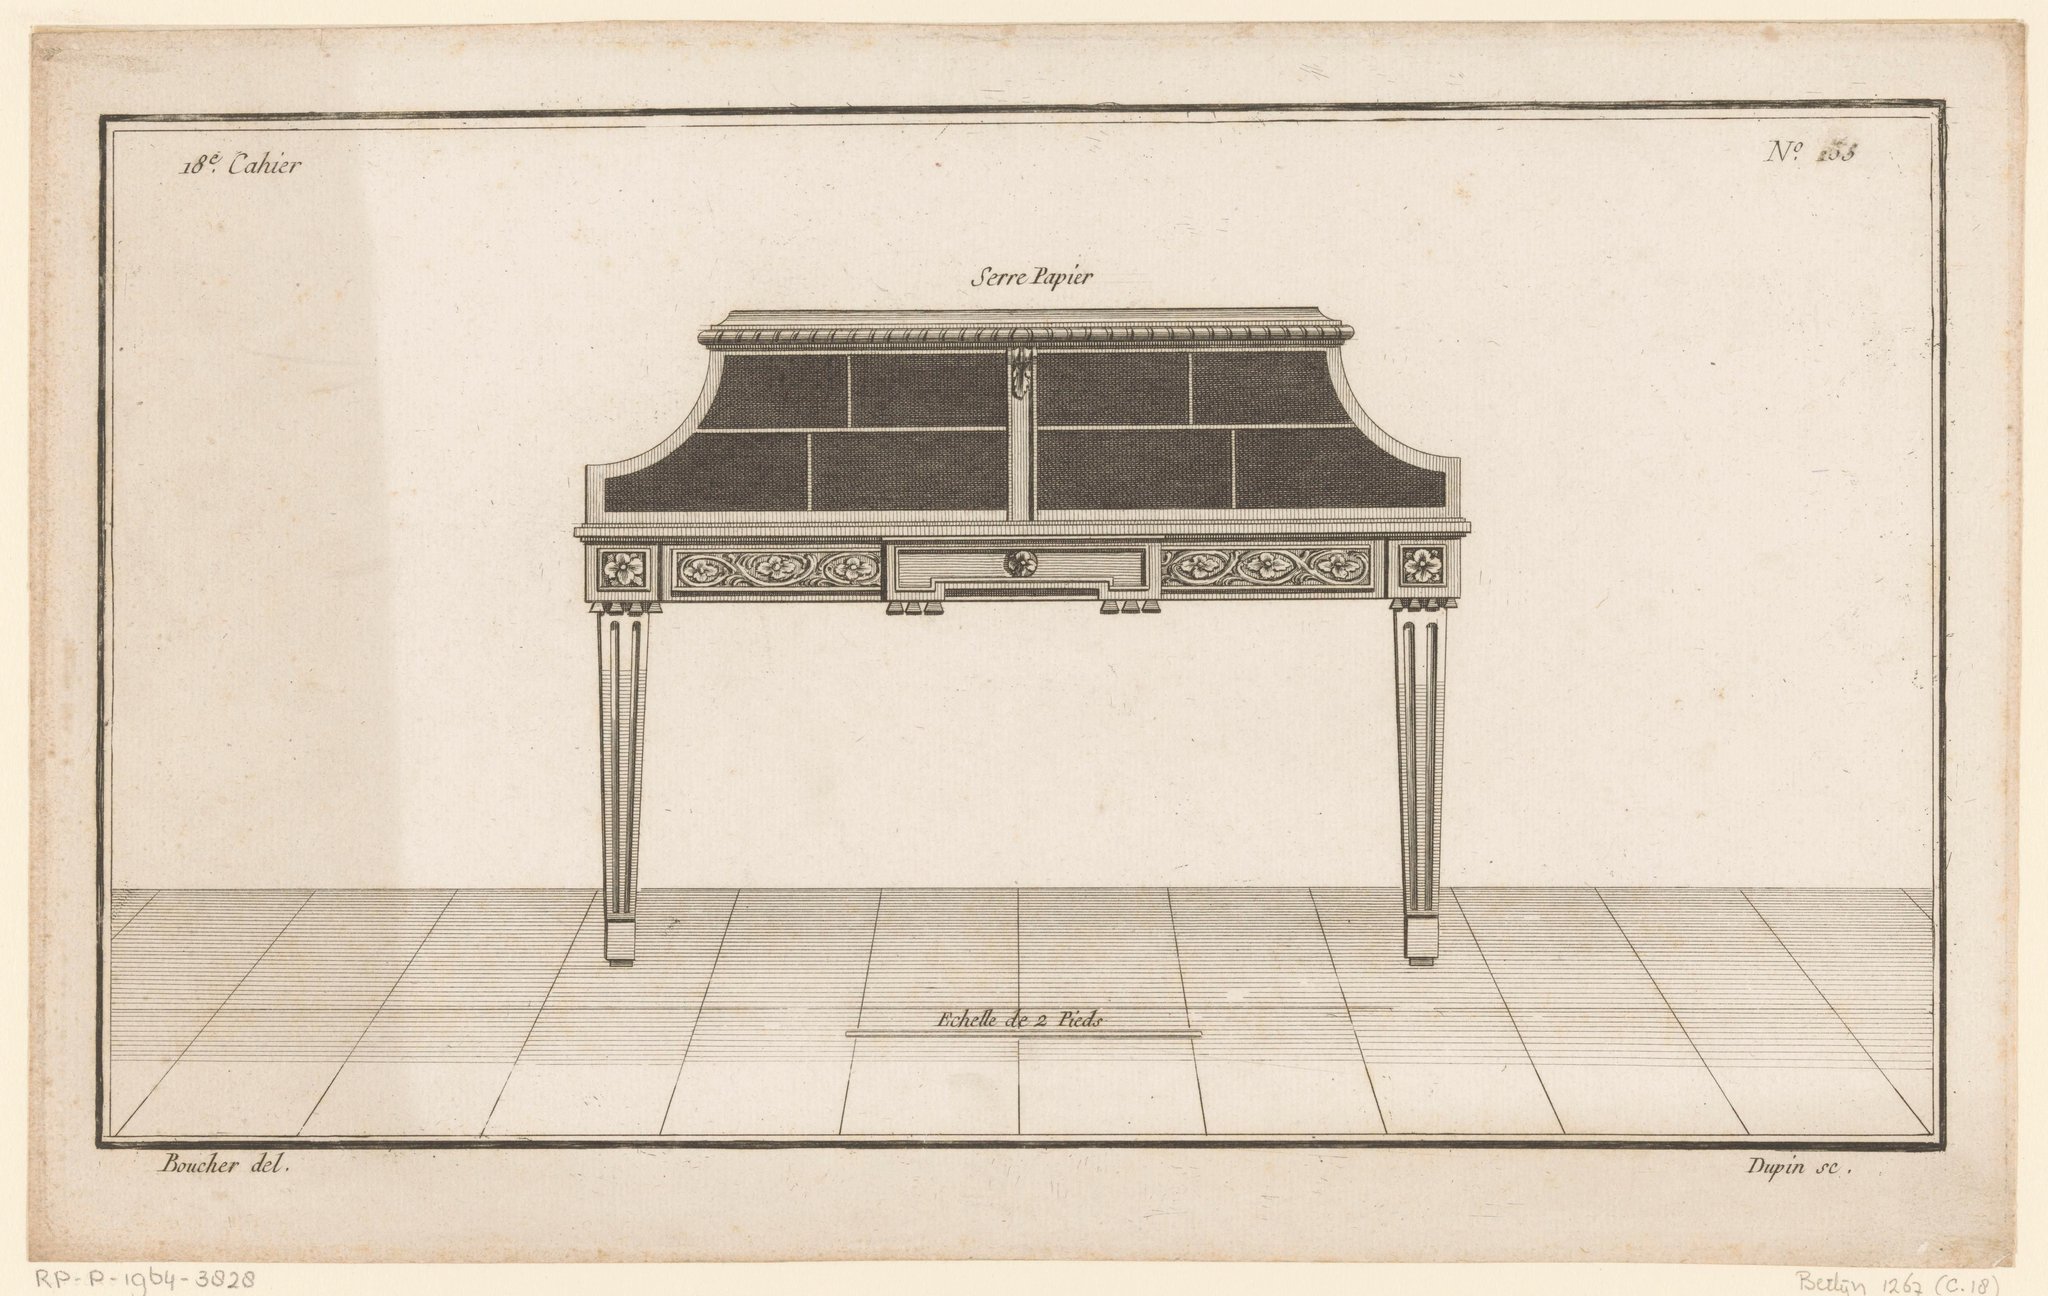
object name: ornament print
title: Secretaires en kasten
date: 1772-1779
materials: paper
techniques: engraving, etching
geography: paris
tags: furniture for storage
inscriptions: collector's mark: Lugt 2760, collector's mark: Lugt 2228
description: Een geornamenteerde kast met loketten om papier in op te bergen. Prentnummer 105.